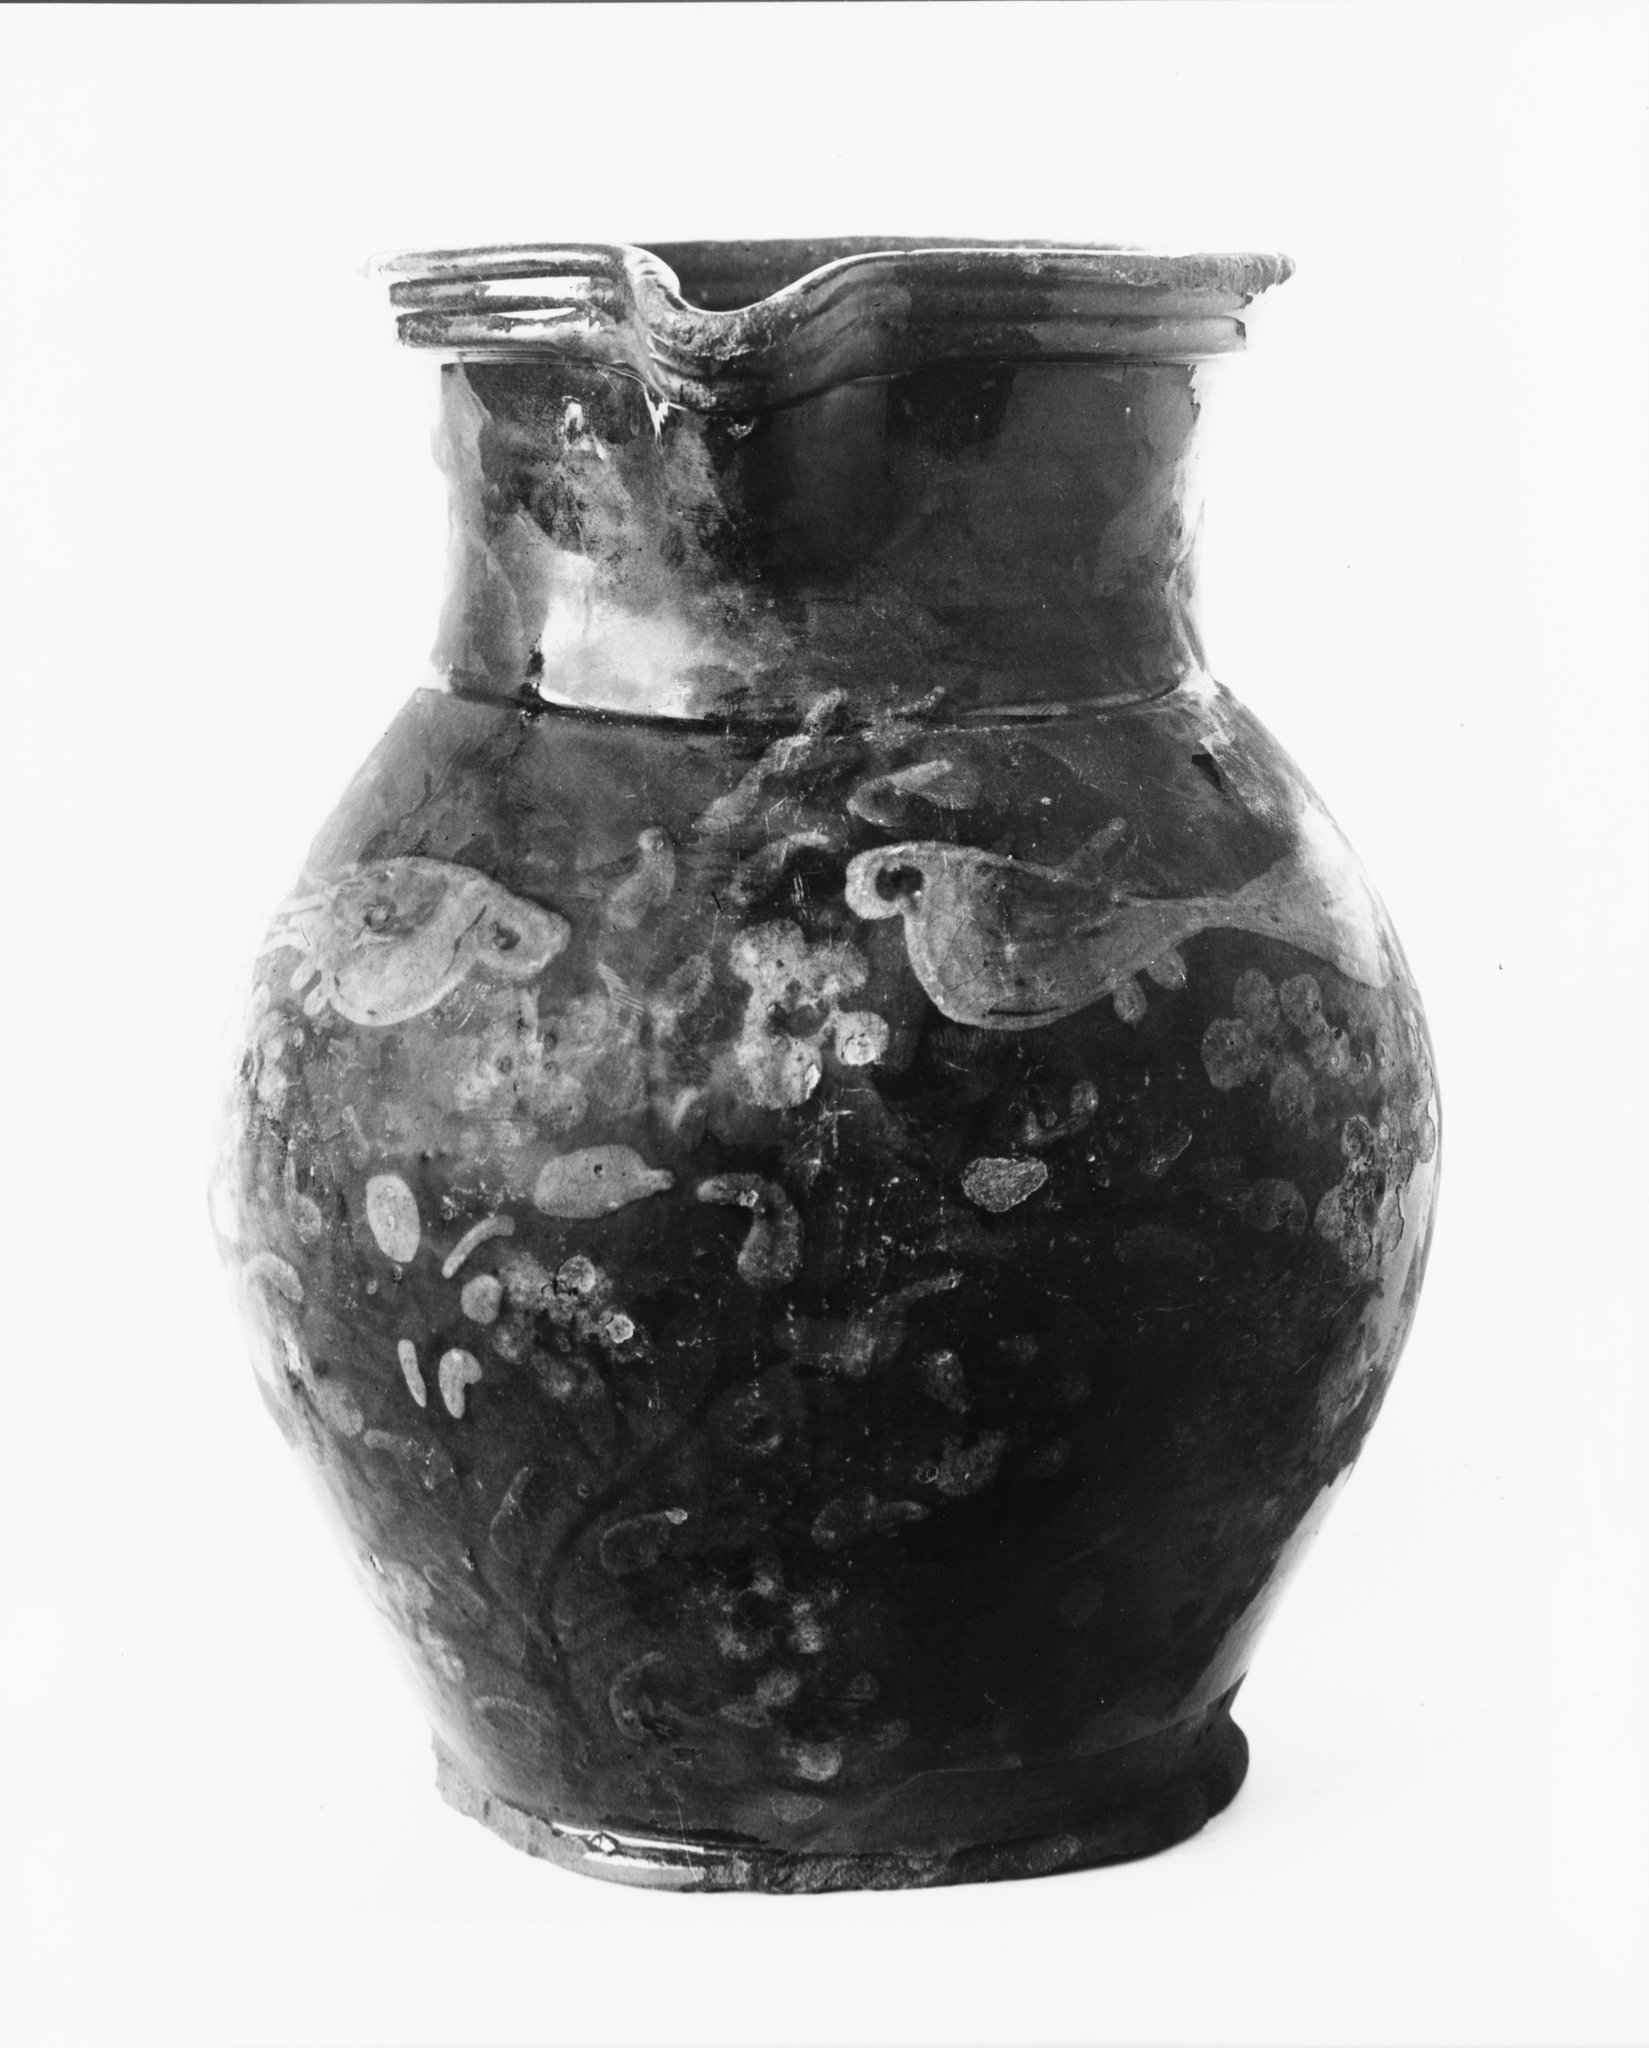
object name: pitcher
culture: american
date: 1840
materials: earthenware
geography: united states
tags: birds